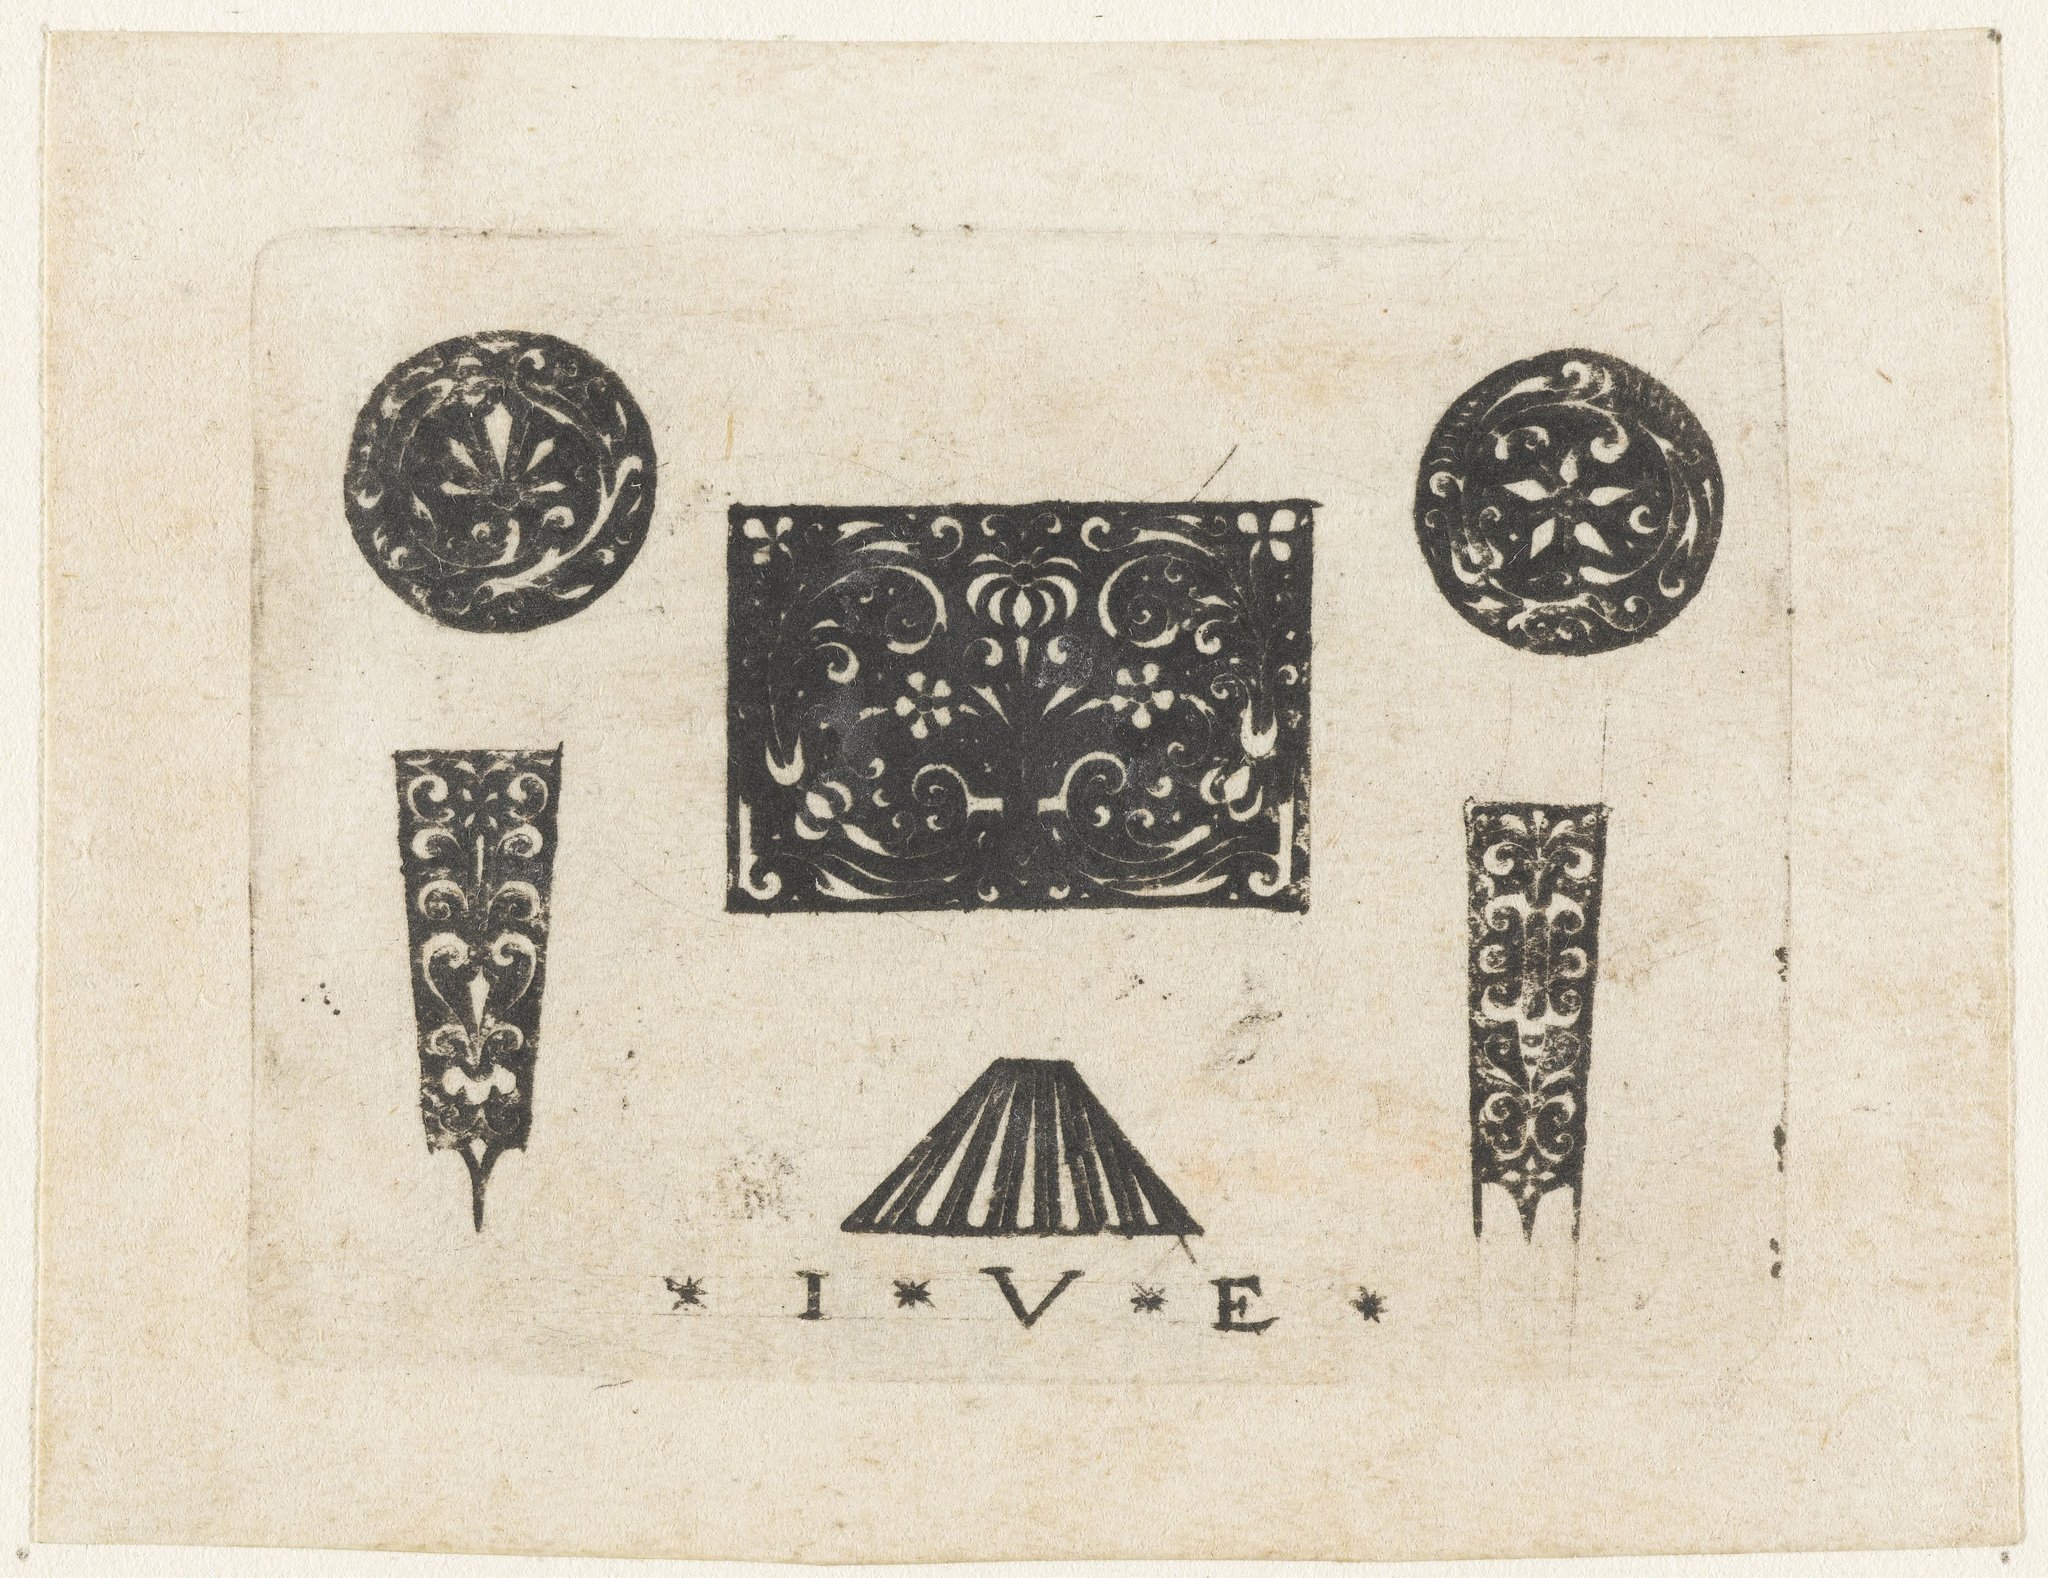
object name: ornament print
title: Kleine ornamenten, gedecoreerd met arabesken en geometrische motieven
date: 1500-1600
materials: paper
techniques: engraving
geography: netherlands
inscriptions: inscription: ‘11’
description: Links - en rechtsboven een medaillon met arabesken. Middenonder een gespikkeld trapeziumvormig ornament. De decoraties zijn wit op een zwart fond. Eén van 3 bladen, elk met zes ornamenten.